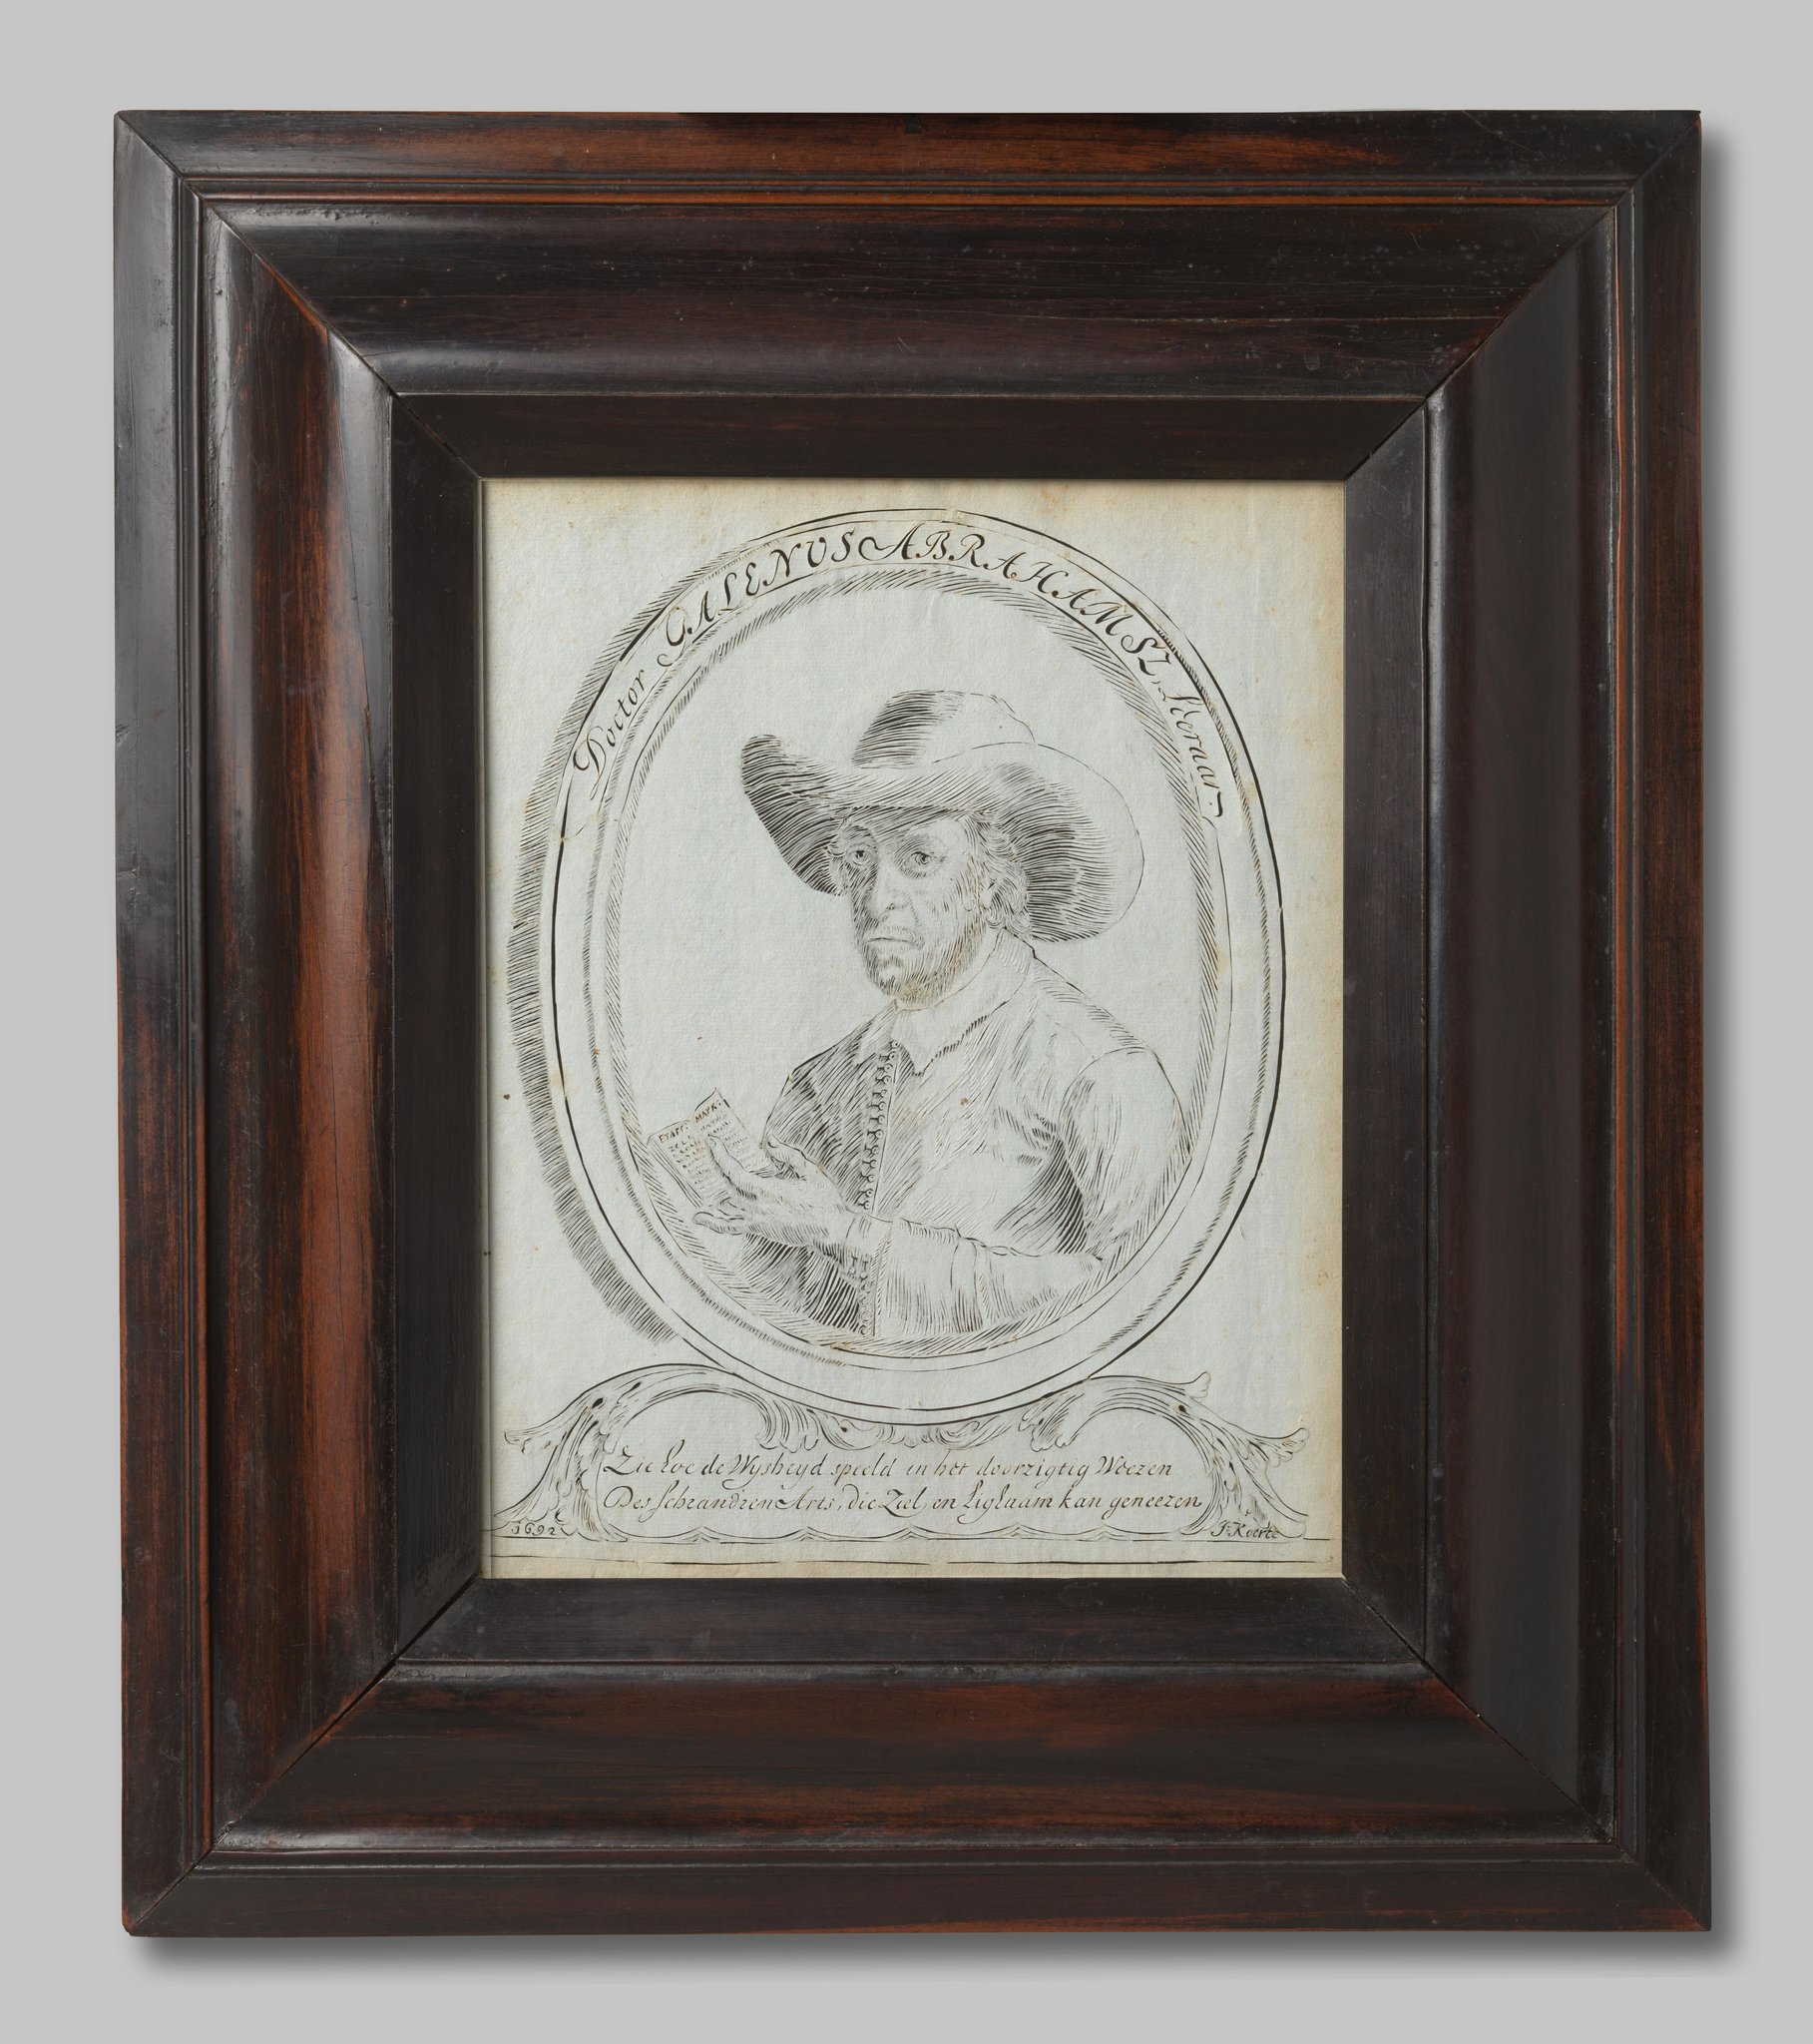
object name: cut paper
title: Ingelijst portret van Galenus Abrahamsz. de Haan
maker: johanna koerten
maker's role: draughtsman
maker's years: 1650-1715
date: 1692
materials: paper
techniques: cutting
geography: amsterdam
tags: amsterdam, galenus abrahamsz. de haan, historical persons, functionaries and dignitaries ~ protestant churches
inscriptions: inscription and date: ‘In een ovaal met onderschrift: “Doctor Galenus Abahamsz, Leeraar“. Daaronder een twee-regelig vers met de tekst: “Zie hoe de Wysheyd speeld in het doorzigtig Weezen/der schrand’ren Arts, die Ziel en Lighaam kan geneezen”. Links onder het jaartal “1692“, rechts de signatuur “J. Koerte“.’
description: Portret van de doopsgezinde predikant en theoloog in een ovaal met de tekst 'Doctor Galenus Abrahamsz. Leeraar' en eronder 'Zie hoe de Wysheyd speeld en het doorzigtig Weezen / Des schrandren Arts, die Ziel, en Lighaam kan geneezen / J. Koerte.